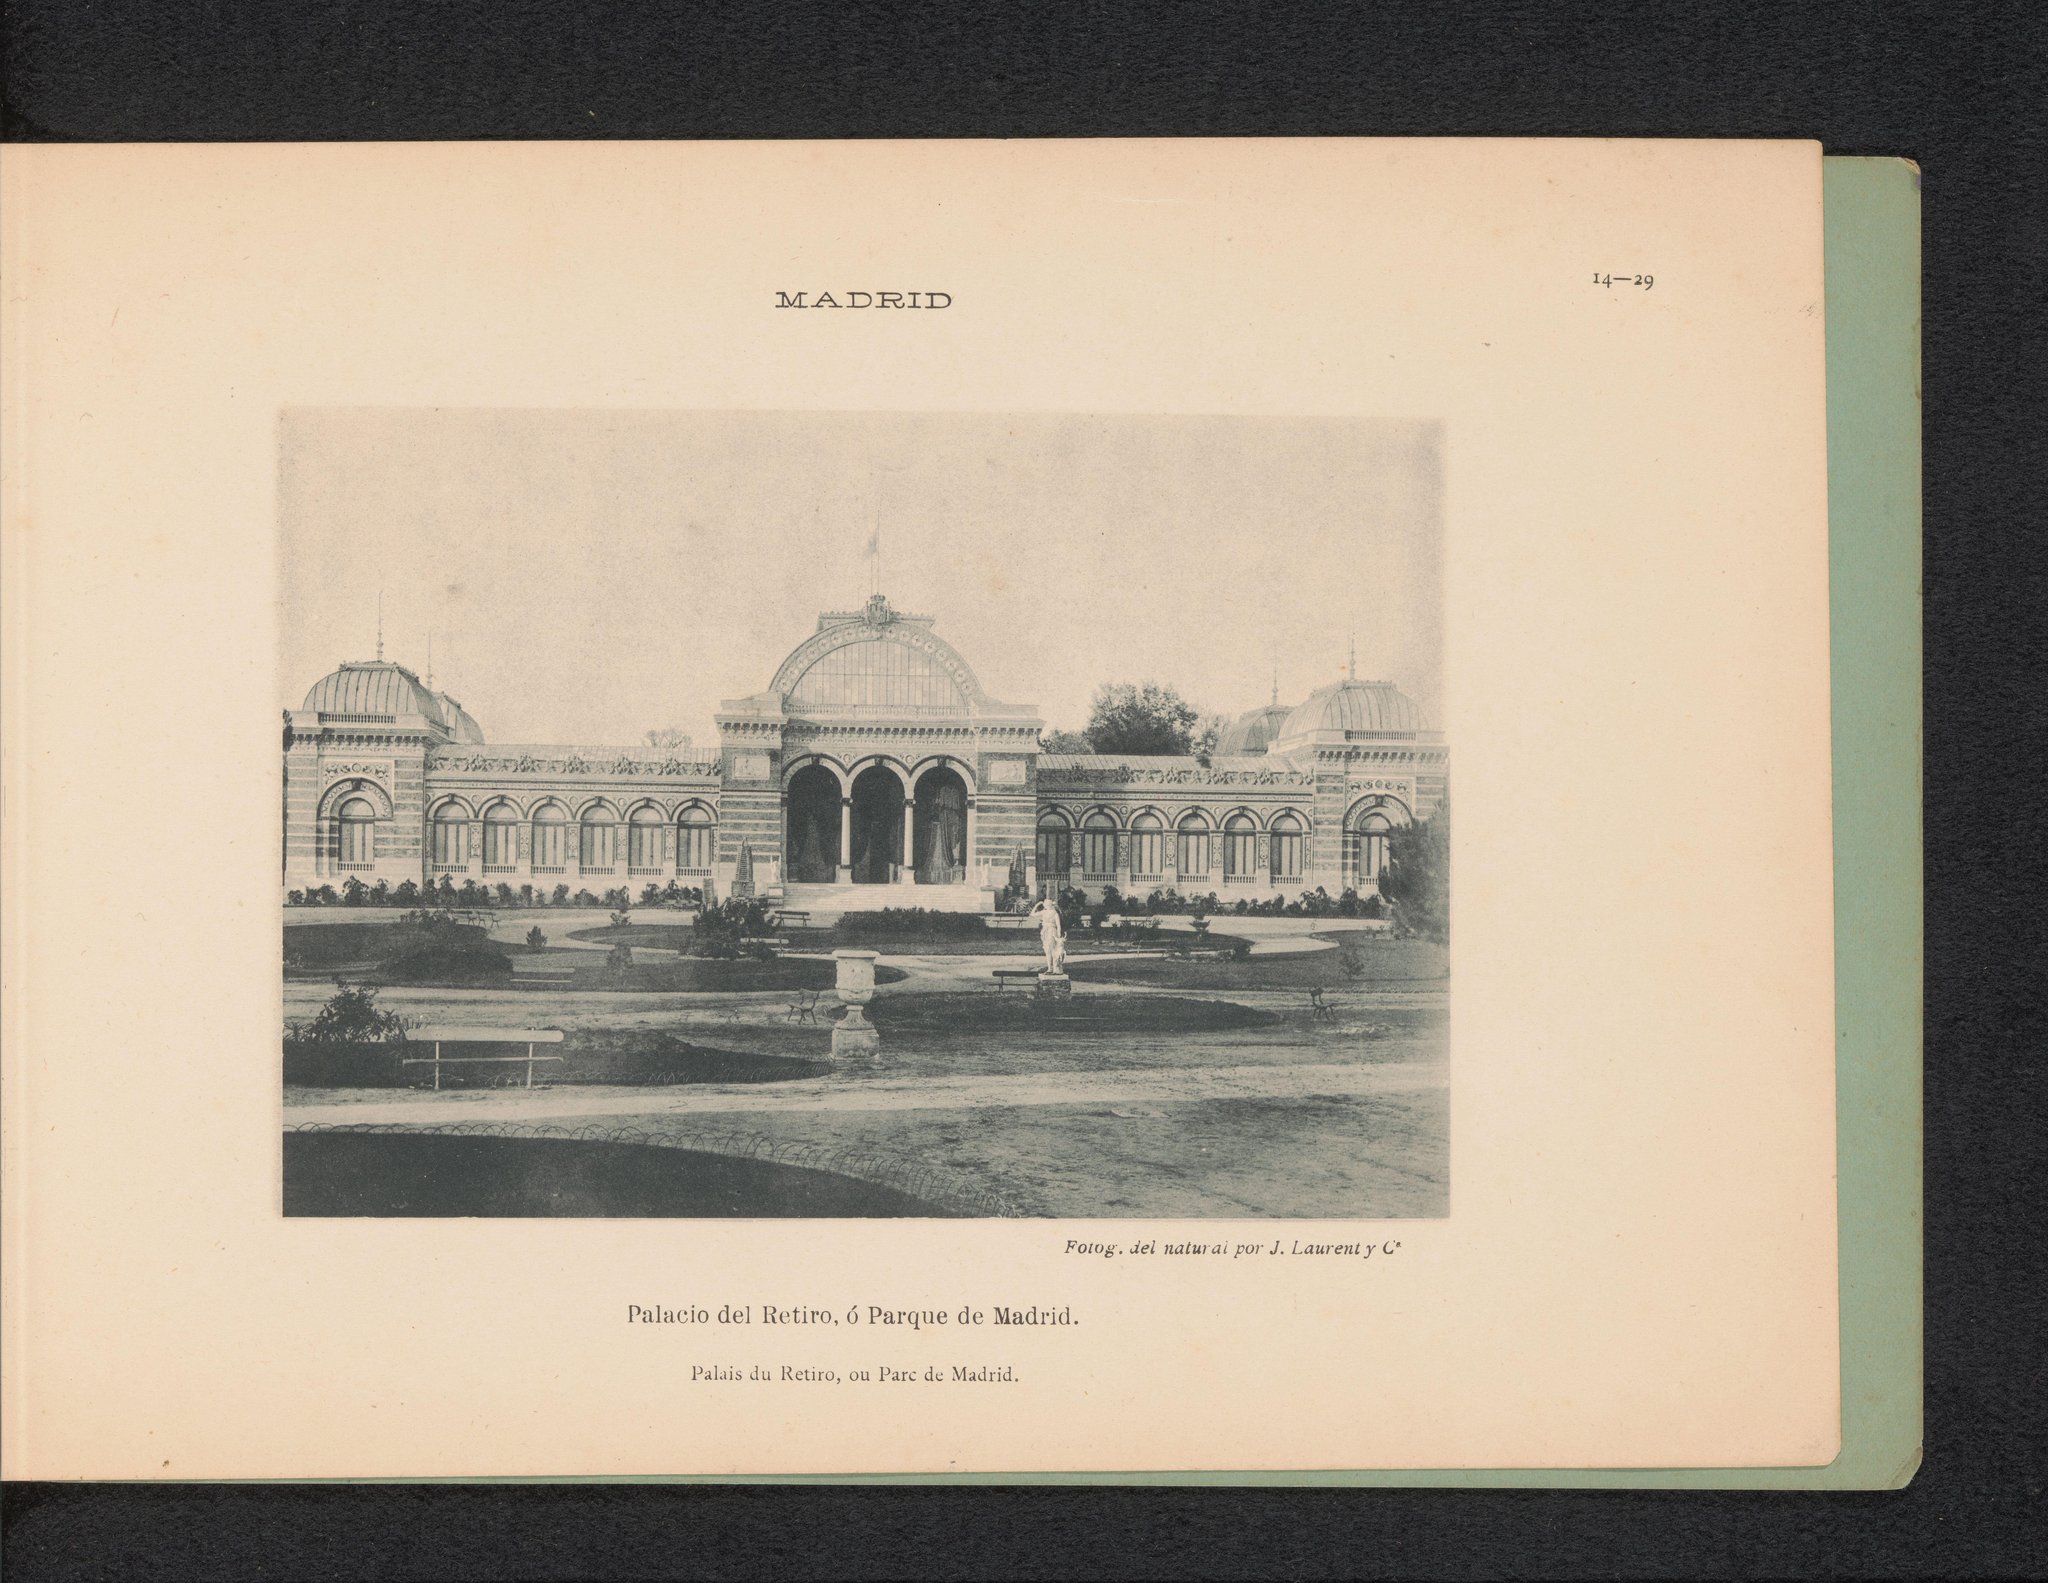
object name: photomechanical print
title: Madrid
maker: juan laurent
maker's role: publisher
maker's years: 1816-1896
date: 1880-1890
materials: paper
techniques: photograph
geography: parque del buen retiro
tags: palace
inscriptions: number: ‘14-29’